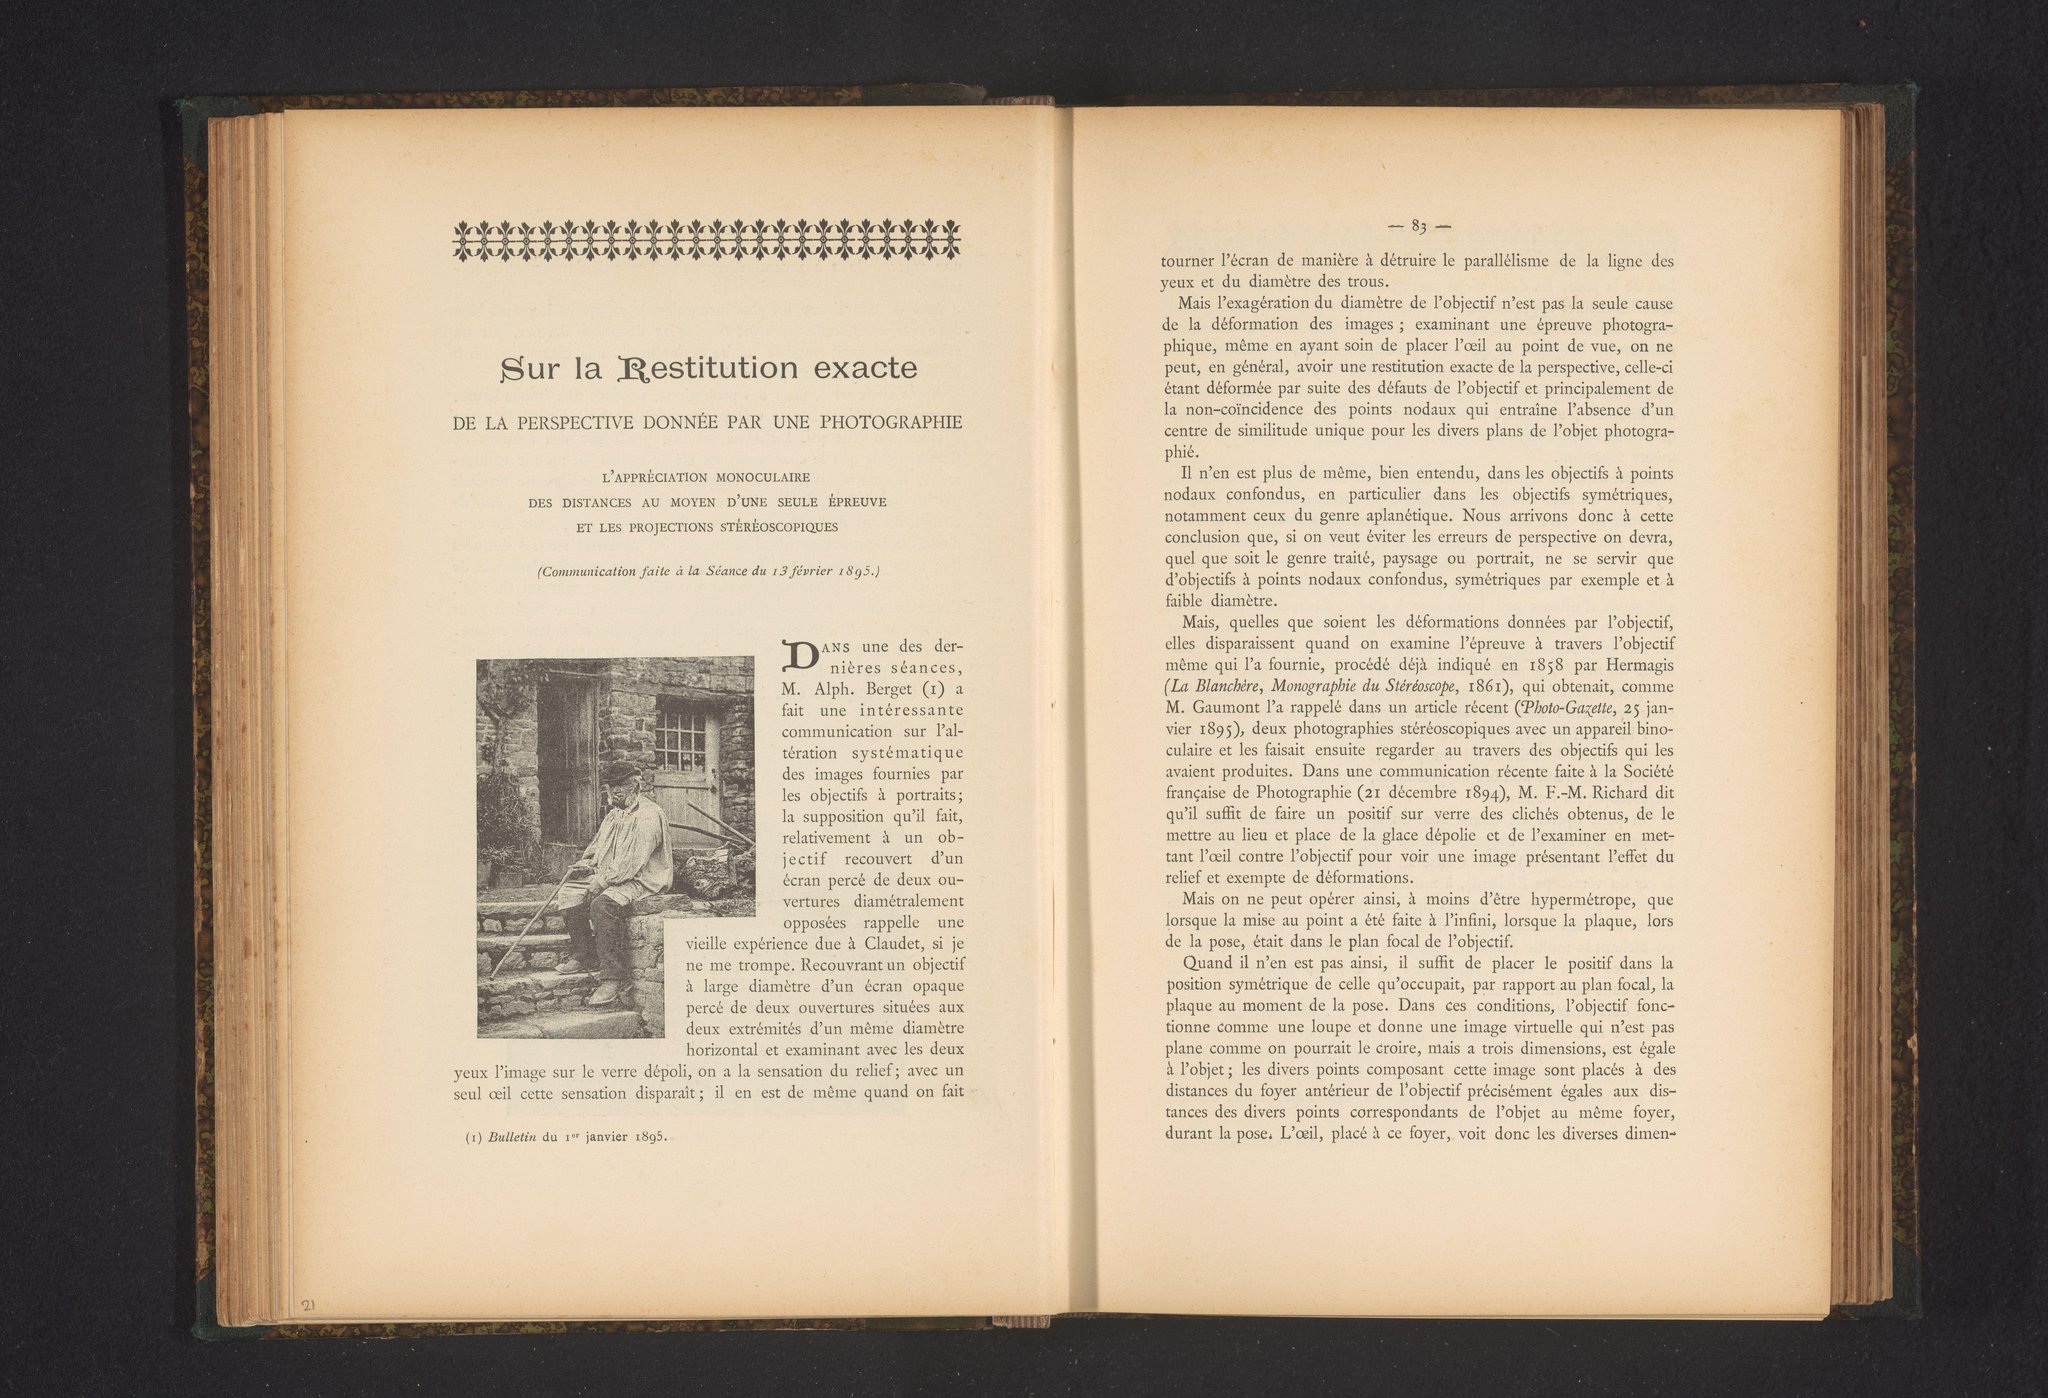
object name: photomechanical print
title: Man zit op een trap en rookt een pijp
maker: Anonymous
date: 1890-1895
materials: paper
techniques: photograph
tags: flight of steps, adult man, pipe ~ tobacco